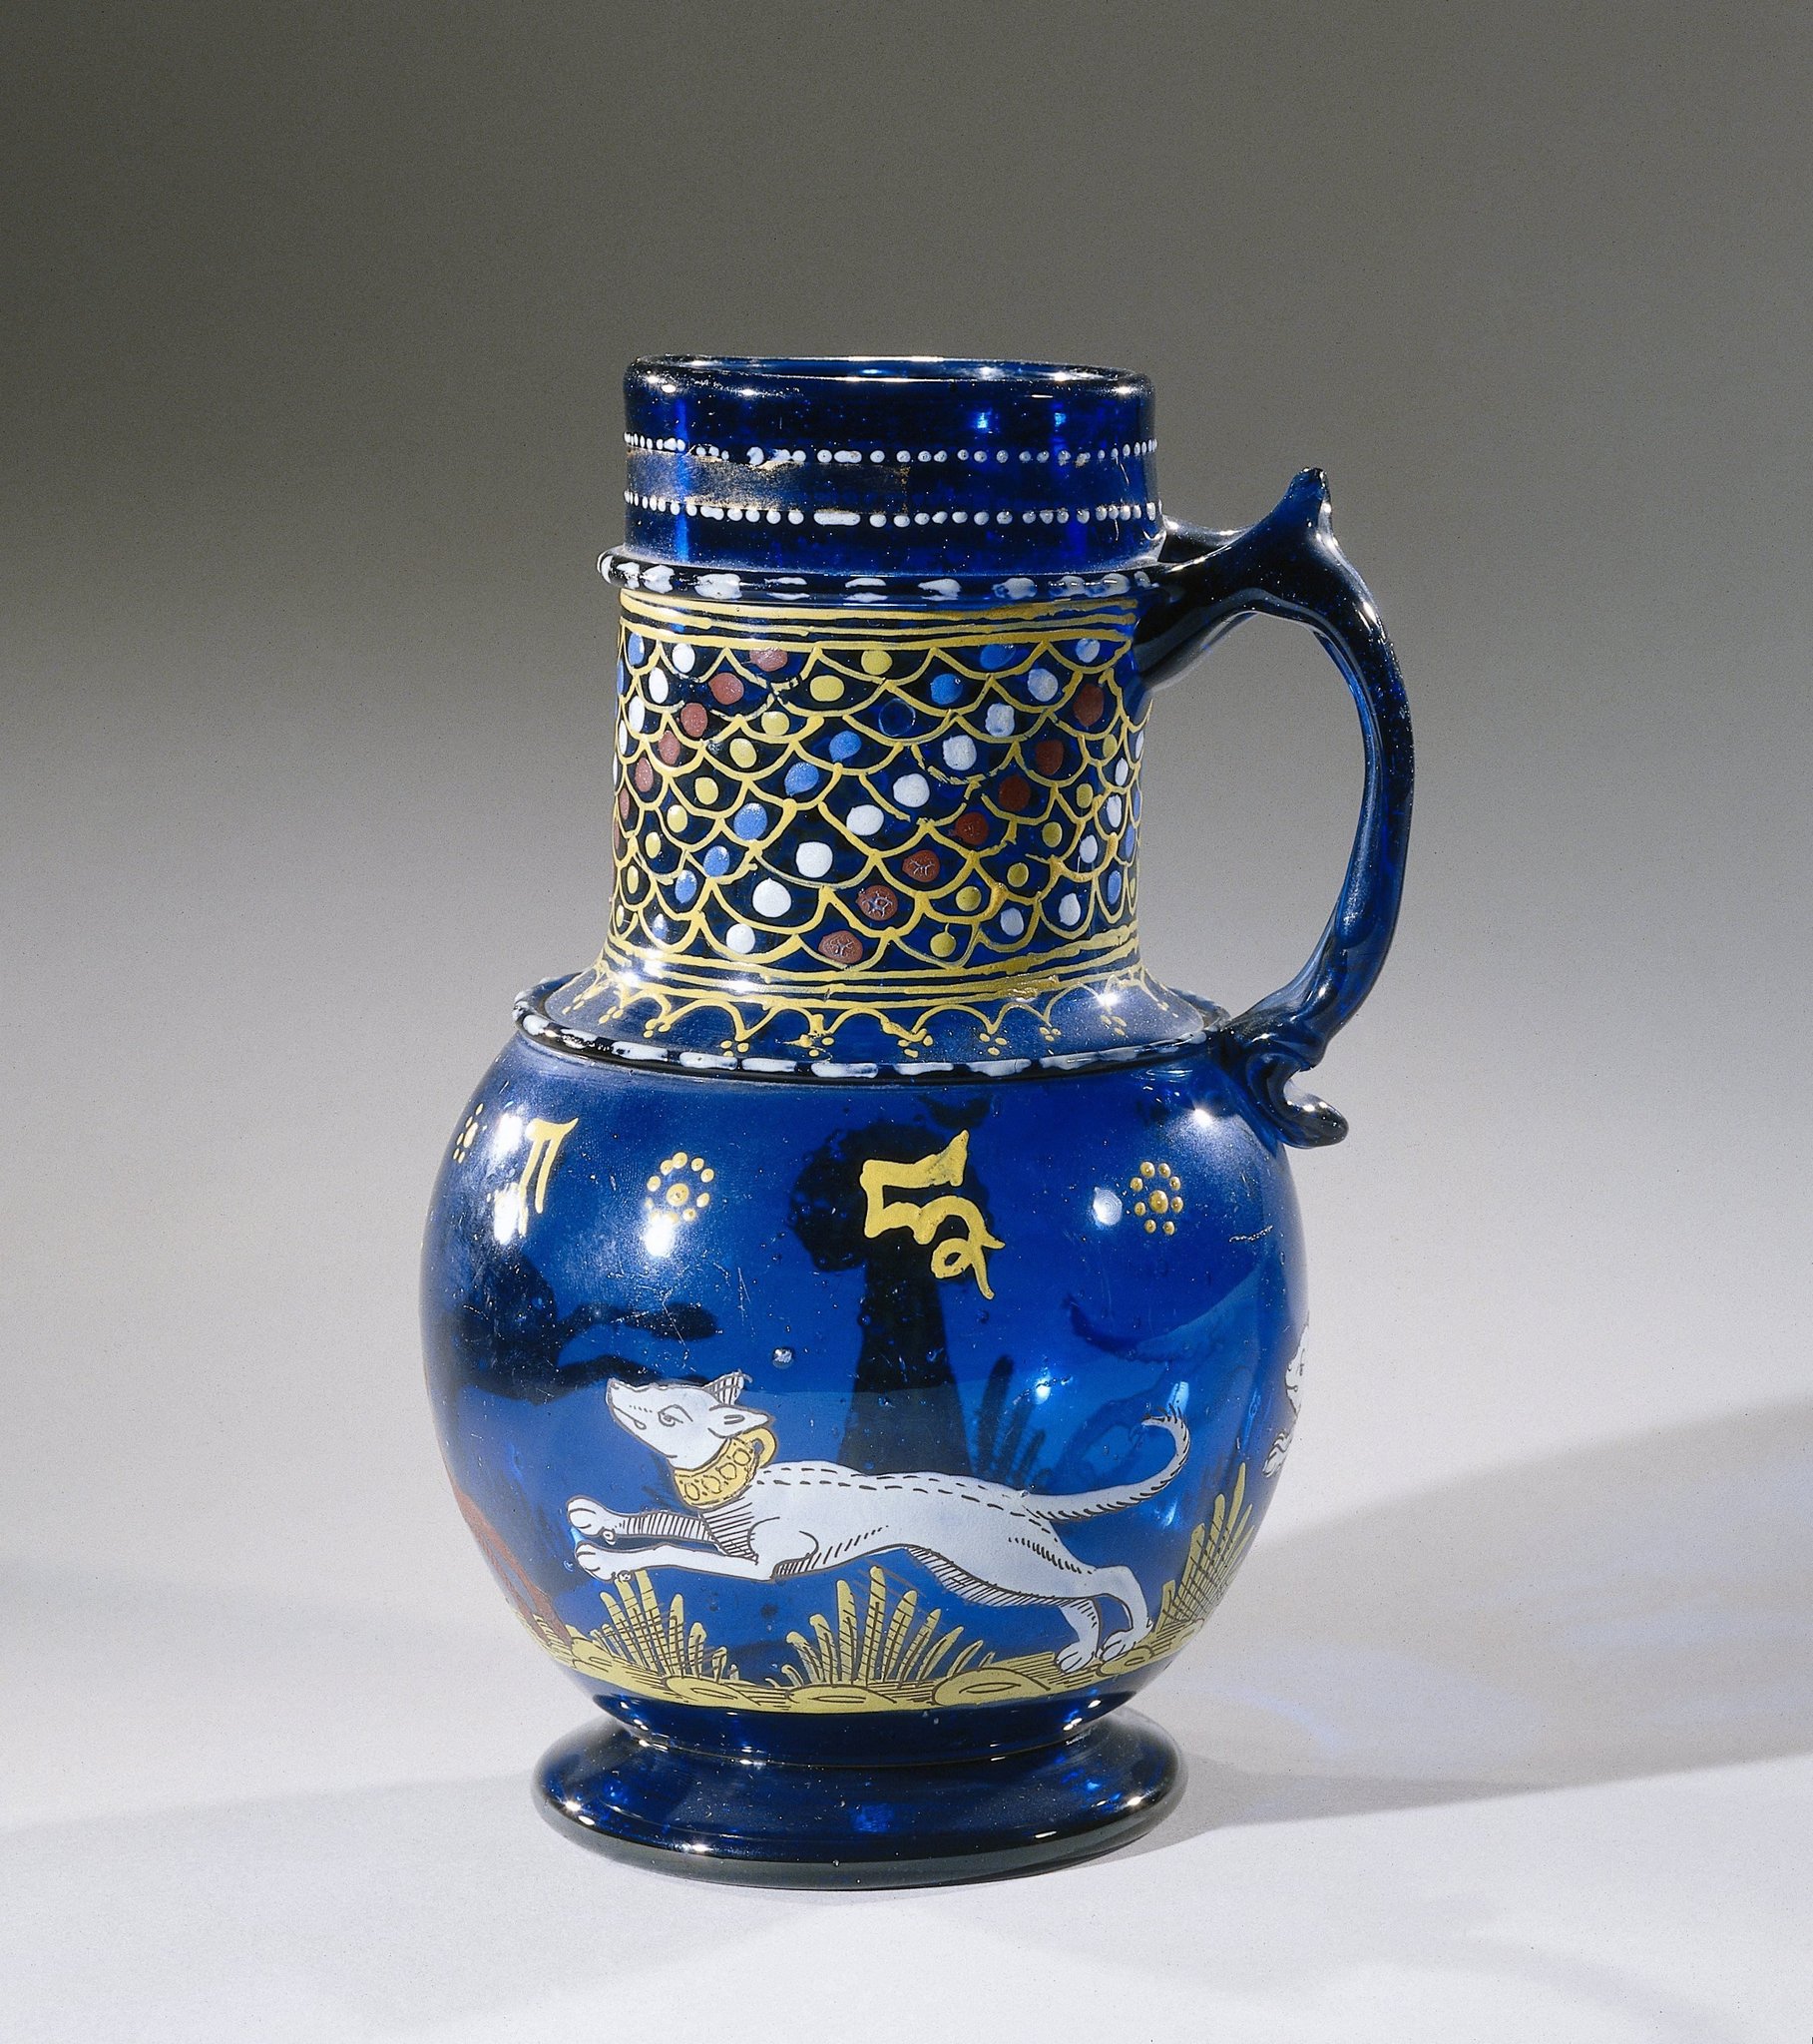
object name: jug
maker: Anonymous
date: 1596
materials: glass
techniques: glassblowing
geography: bohemia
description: Cobalt-blue glass, like that of this painted jug, is said to have been invented in the 16th century by glassmaker Christoph Schürer, a member of a famous Bohemian glass family. The remarkable rich colour forms a stunning background for the two white dogs chasing a deer.